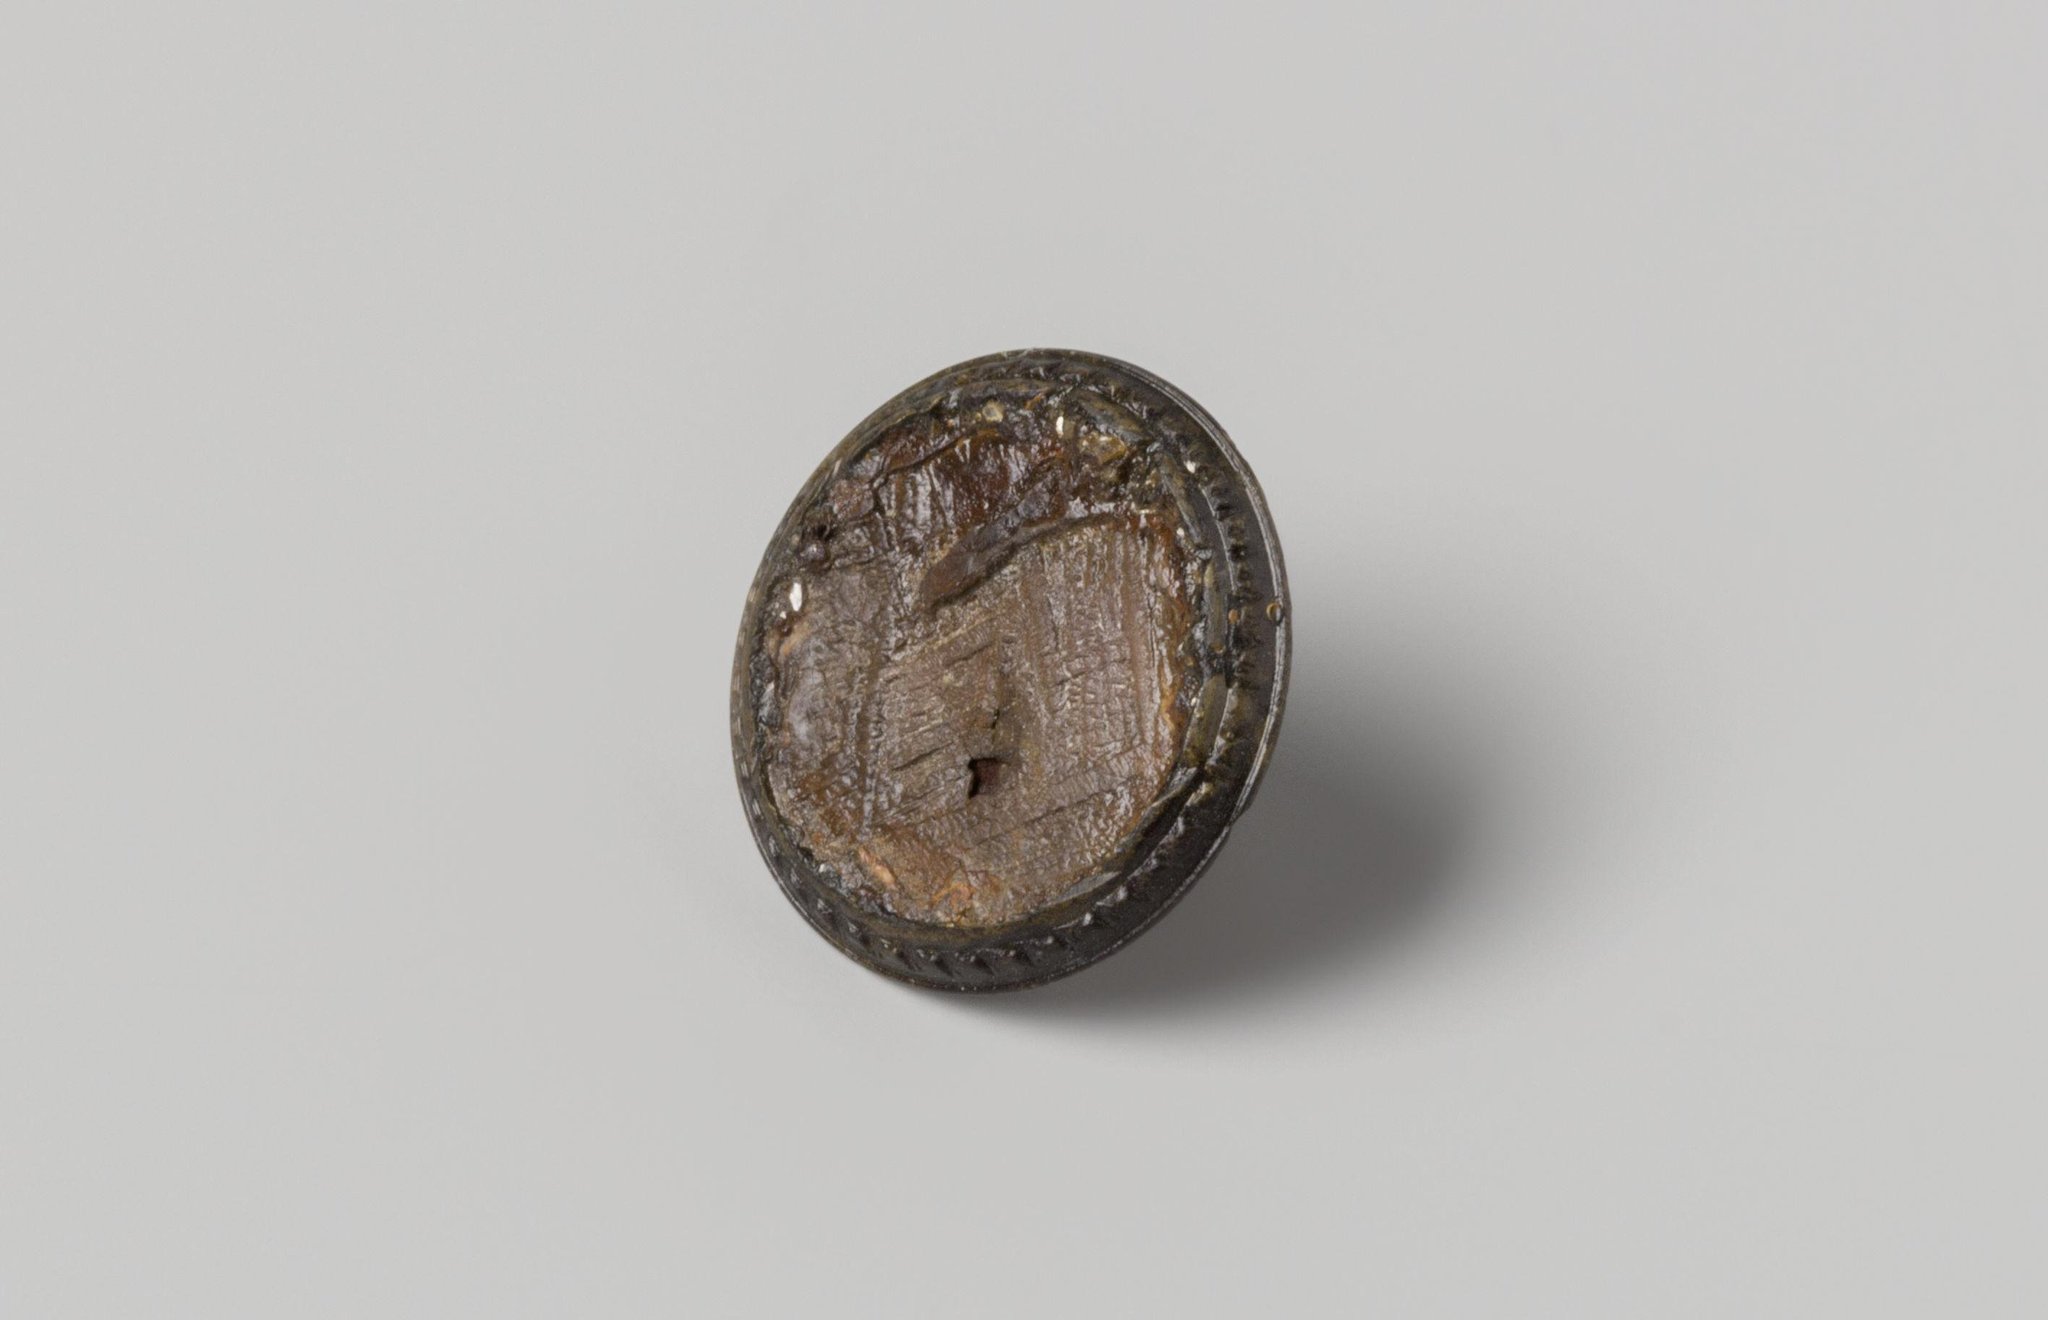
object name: button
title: Knoop uit het wrak van de Oost-Indiëvaarder Hollandia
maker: Anonymous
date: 1700-1743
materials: copper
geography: netherlands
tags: verenigde oostindische compagnie, hollandia (schip), annet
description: Knoop. (1) eroded, flat base, beaded rim (1.3d, 0.2t), (stone- ) setting missing, key-shank